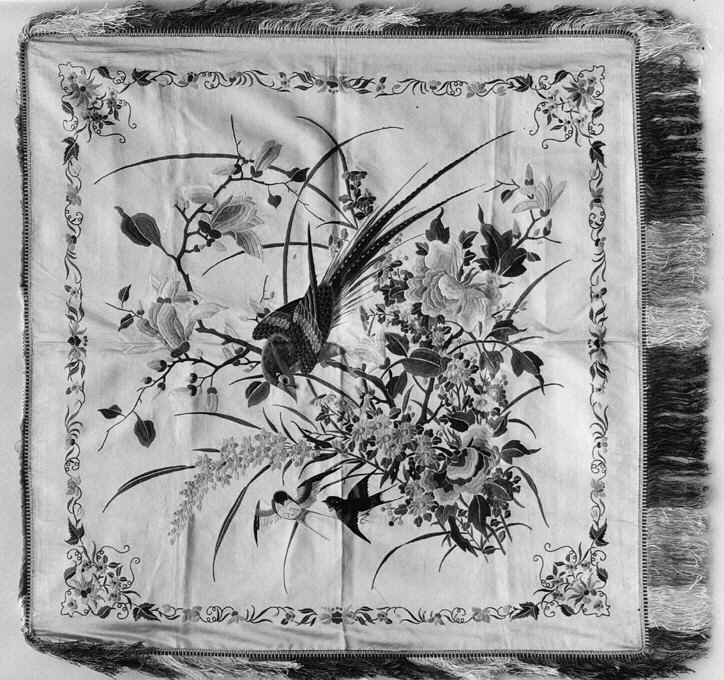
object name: pillow cover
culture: chinese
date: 1801-1900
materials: silk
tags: flowers